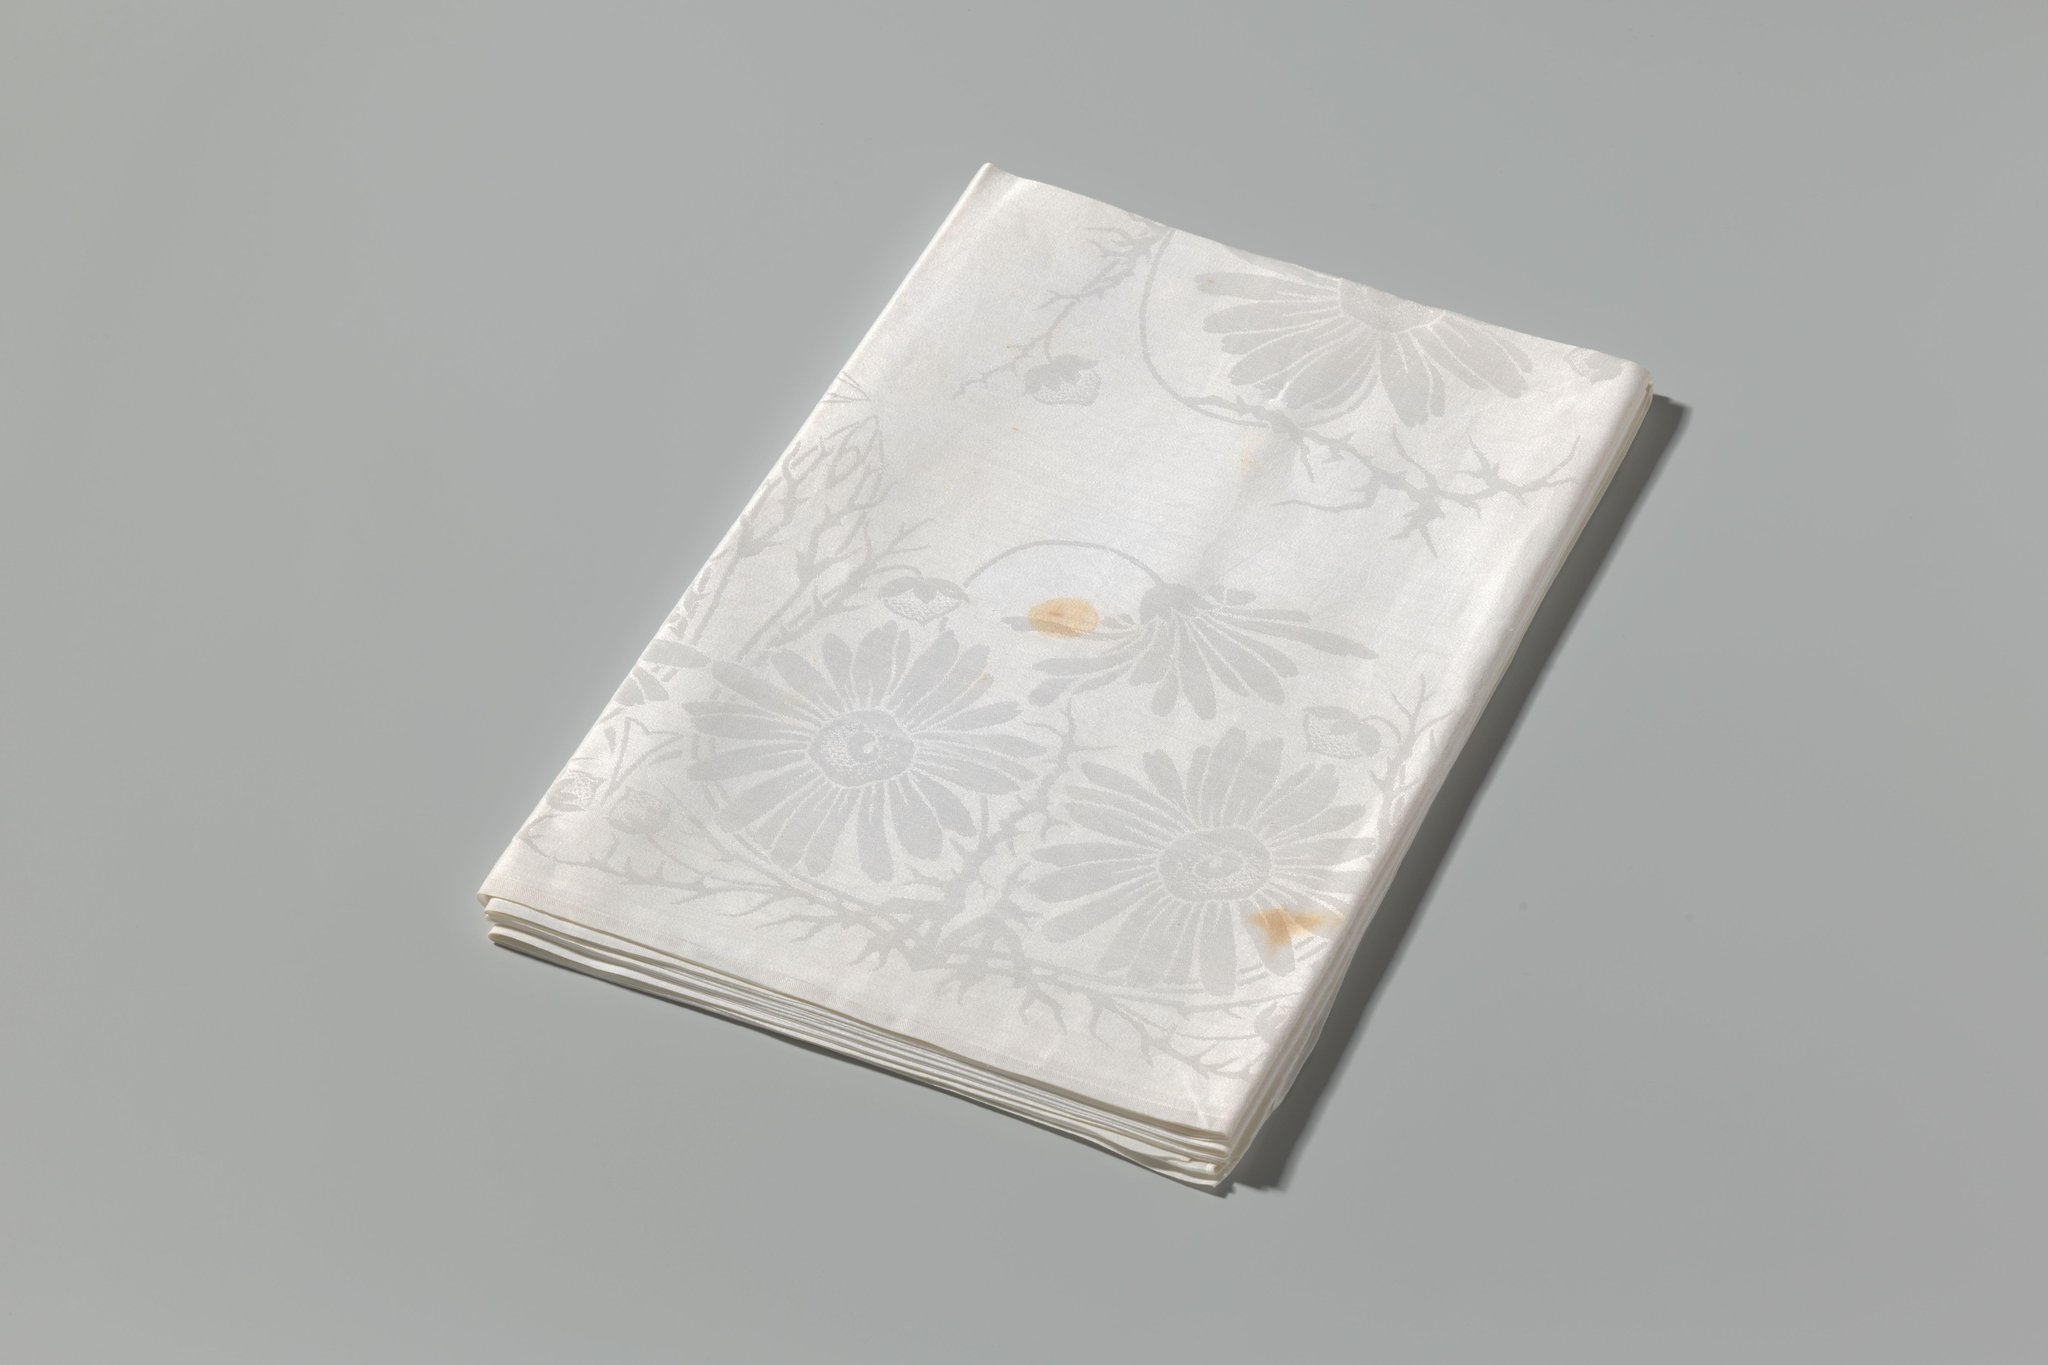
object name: tablecloth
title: Tafellaken van linnendamast met dessin Marguerite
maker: cornelis van der sluys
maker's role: print maker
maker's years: 1881-1944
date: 1904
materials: linen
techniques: damask, weave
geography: eindhoven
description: Tafellaken van linnendamast met een bloempatroon: motief Marguerite, dessin nr. 500. Bij het tafellaken horen dertien servetten en twaalf vingerdoeken.